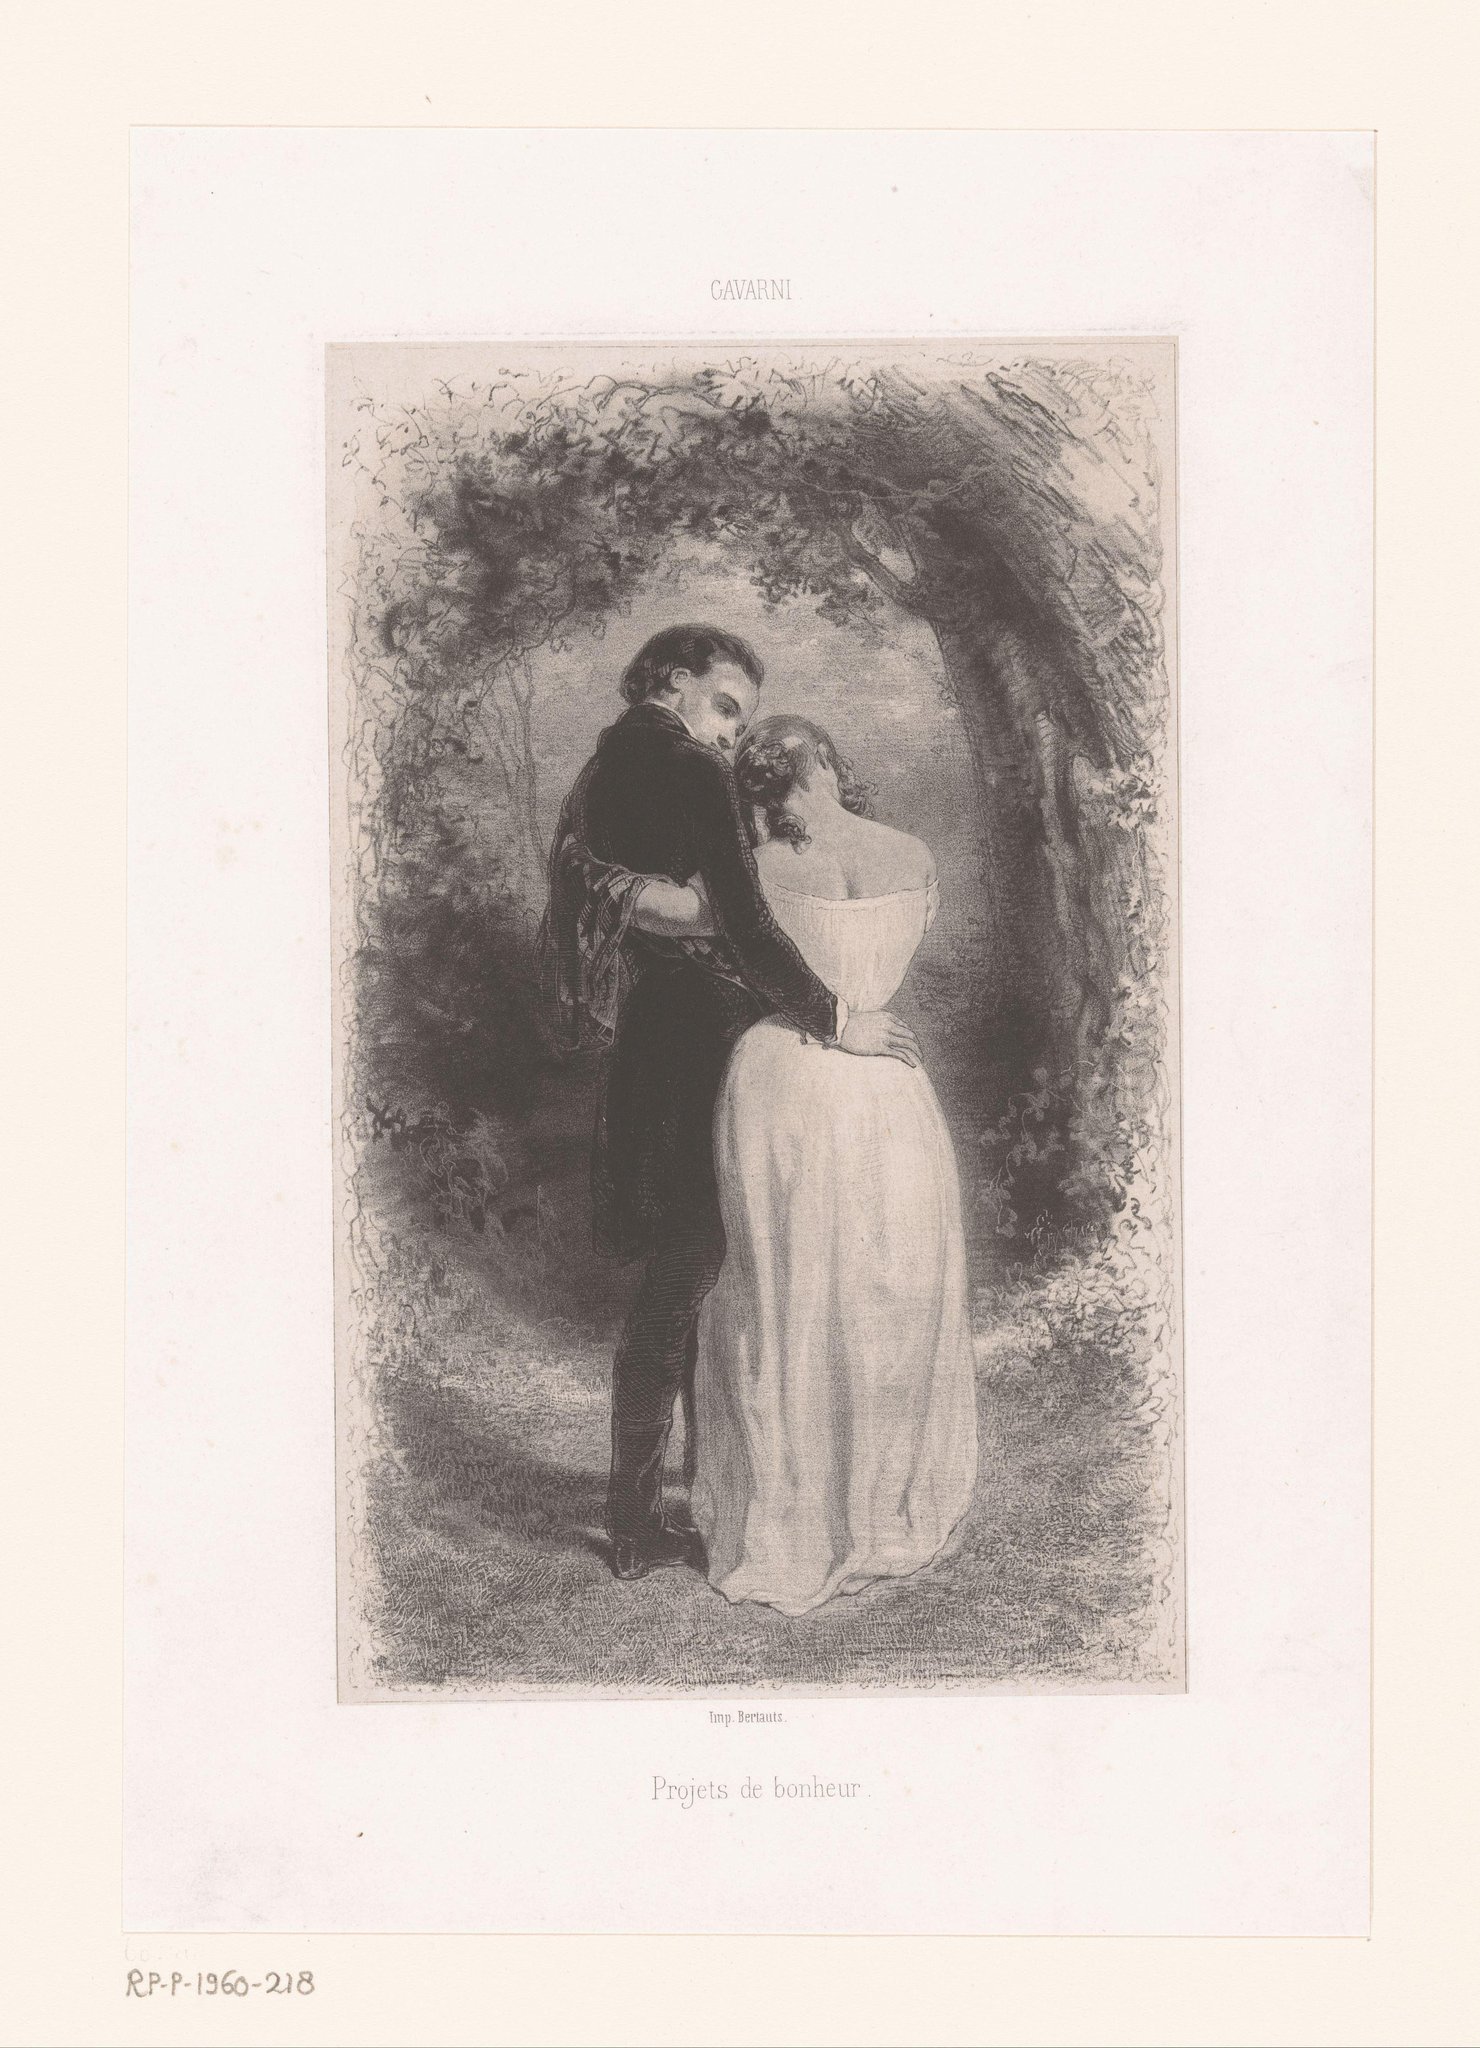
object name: print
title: Liefdespaar op een bospad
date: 1843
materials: paper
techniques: lithograph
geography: paris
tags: (lovers) embracing each other, 'symplegma', forest path or lane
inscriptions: collector's mark: Lugt 2228a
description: Prent gebruikt voor: Curmer, L. Les Beaux-Arts. Illustration des Arts et de la Littérature. Parijs: L. Curmer, 1843. Vol. 1, 25e livraison.